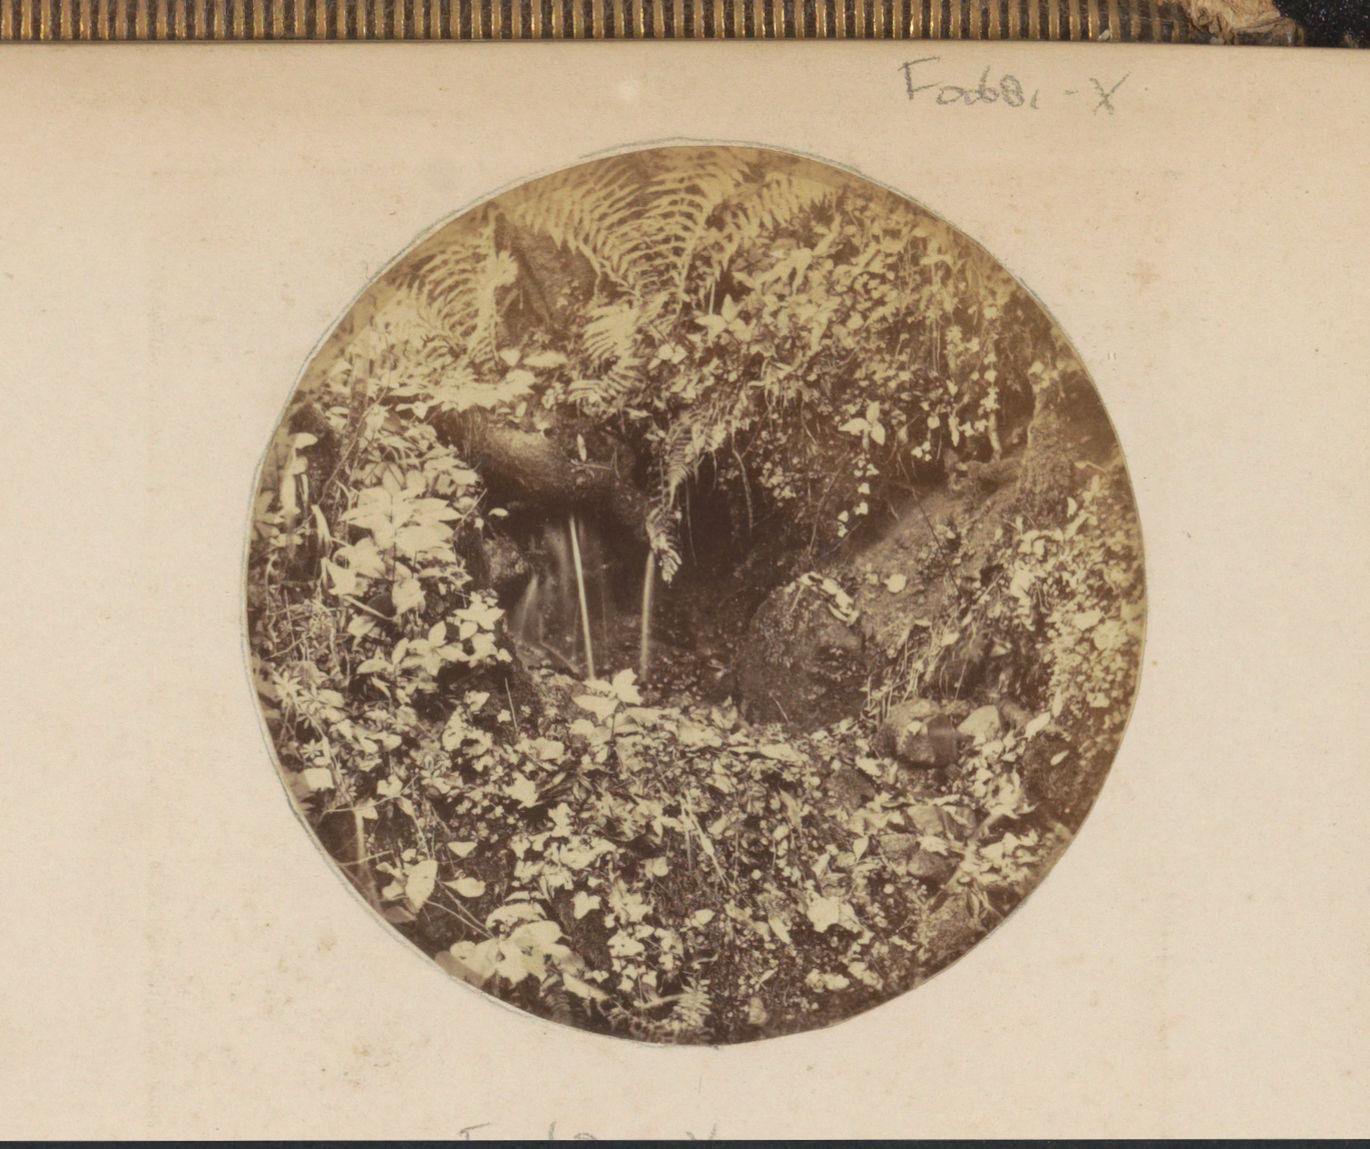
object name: photograph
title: Varen en andere bosplanten in Engeland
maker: Anonymous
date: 1850-1870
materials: paper, photographic support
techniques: albumen print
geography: england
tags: plants; vegetation, england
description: Onderdeel van Album met foto's van bezienswaardigheden en landschappen in Engeland en van kunst.